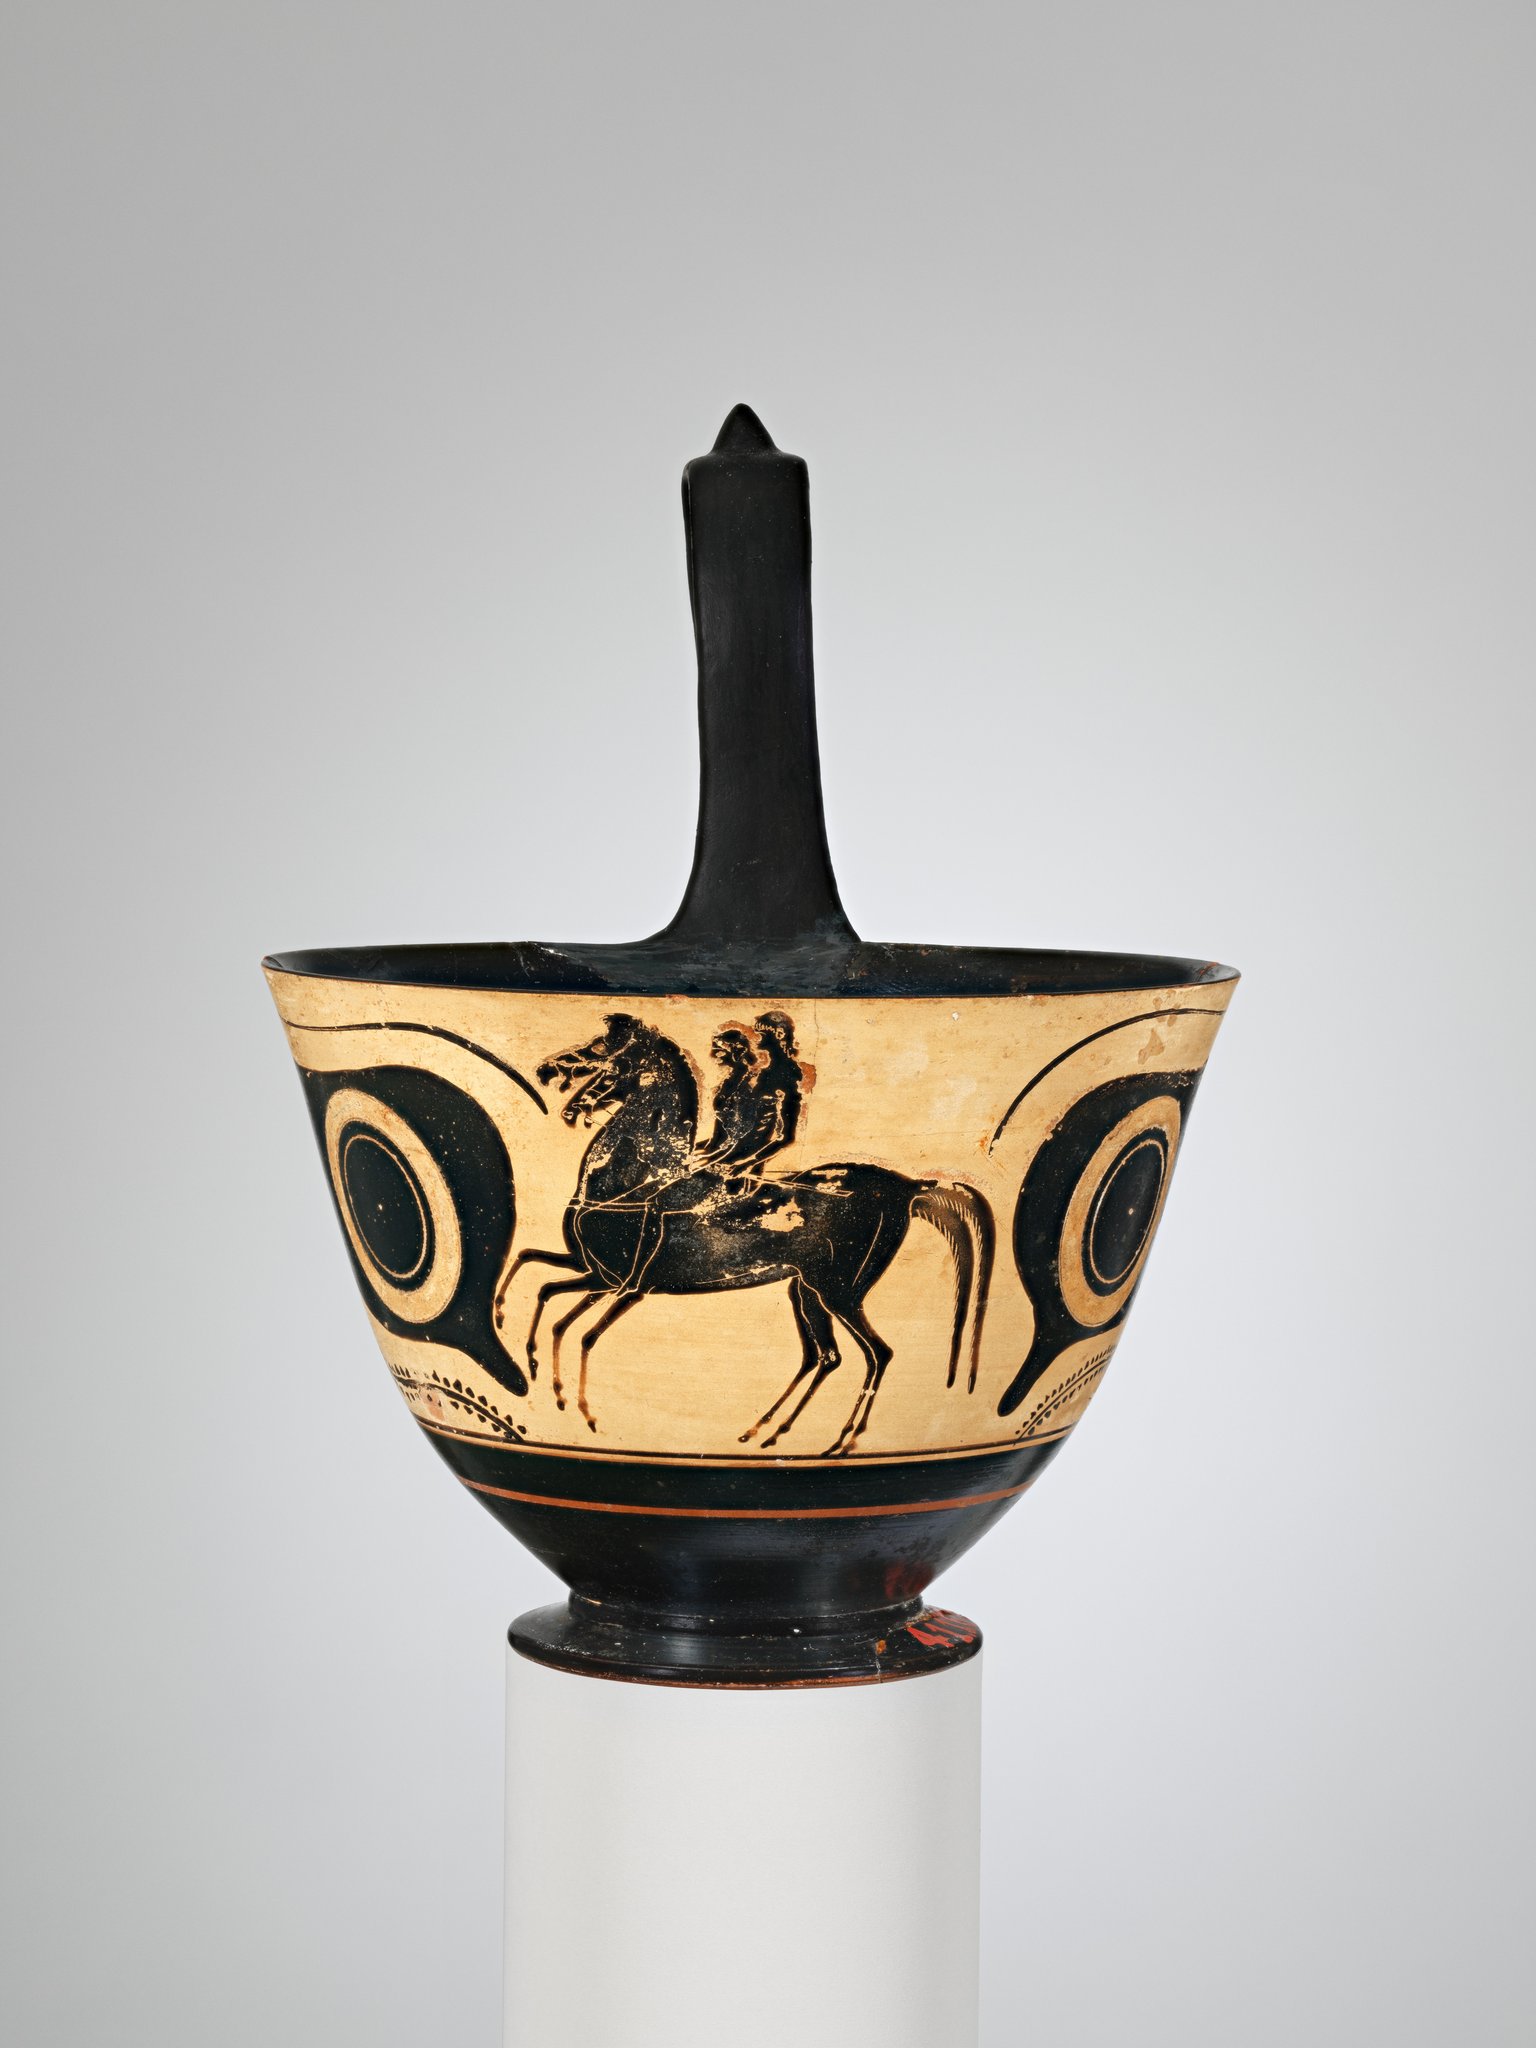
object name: kyathos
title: Terracotta kyathos (cup-shaped ladle)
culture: greek, attic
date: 520-510 BCE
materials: terracotta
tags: eyes,horses,panthers